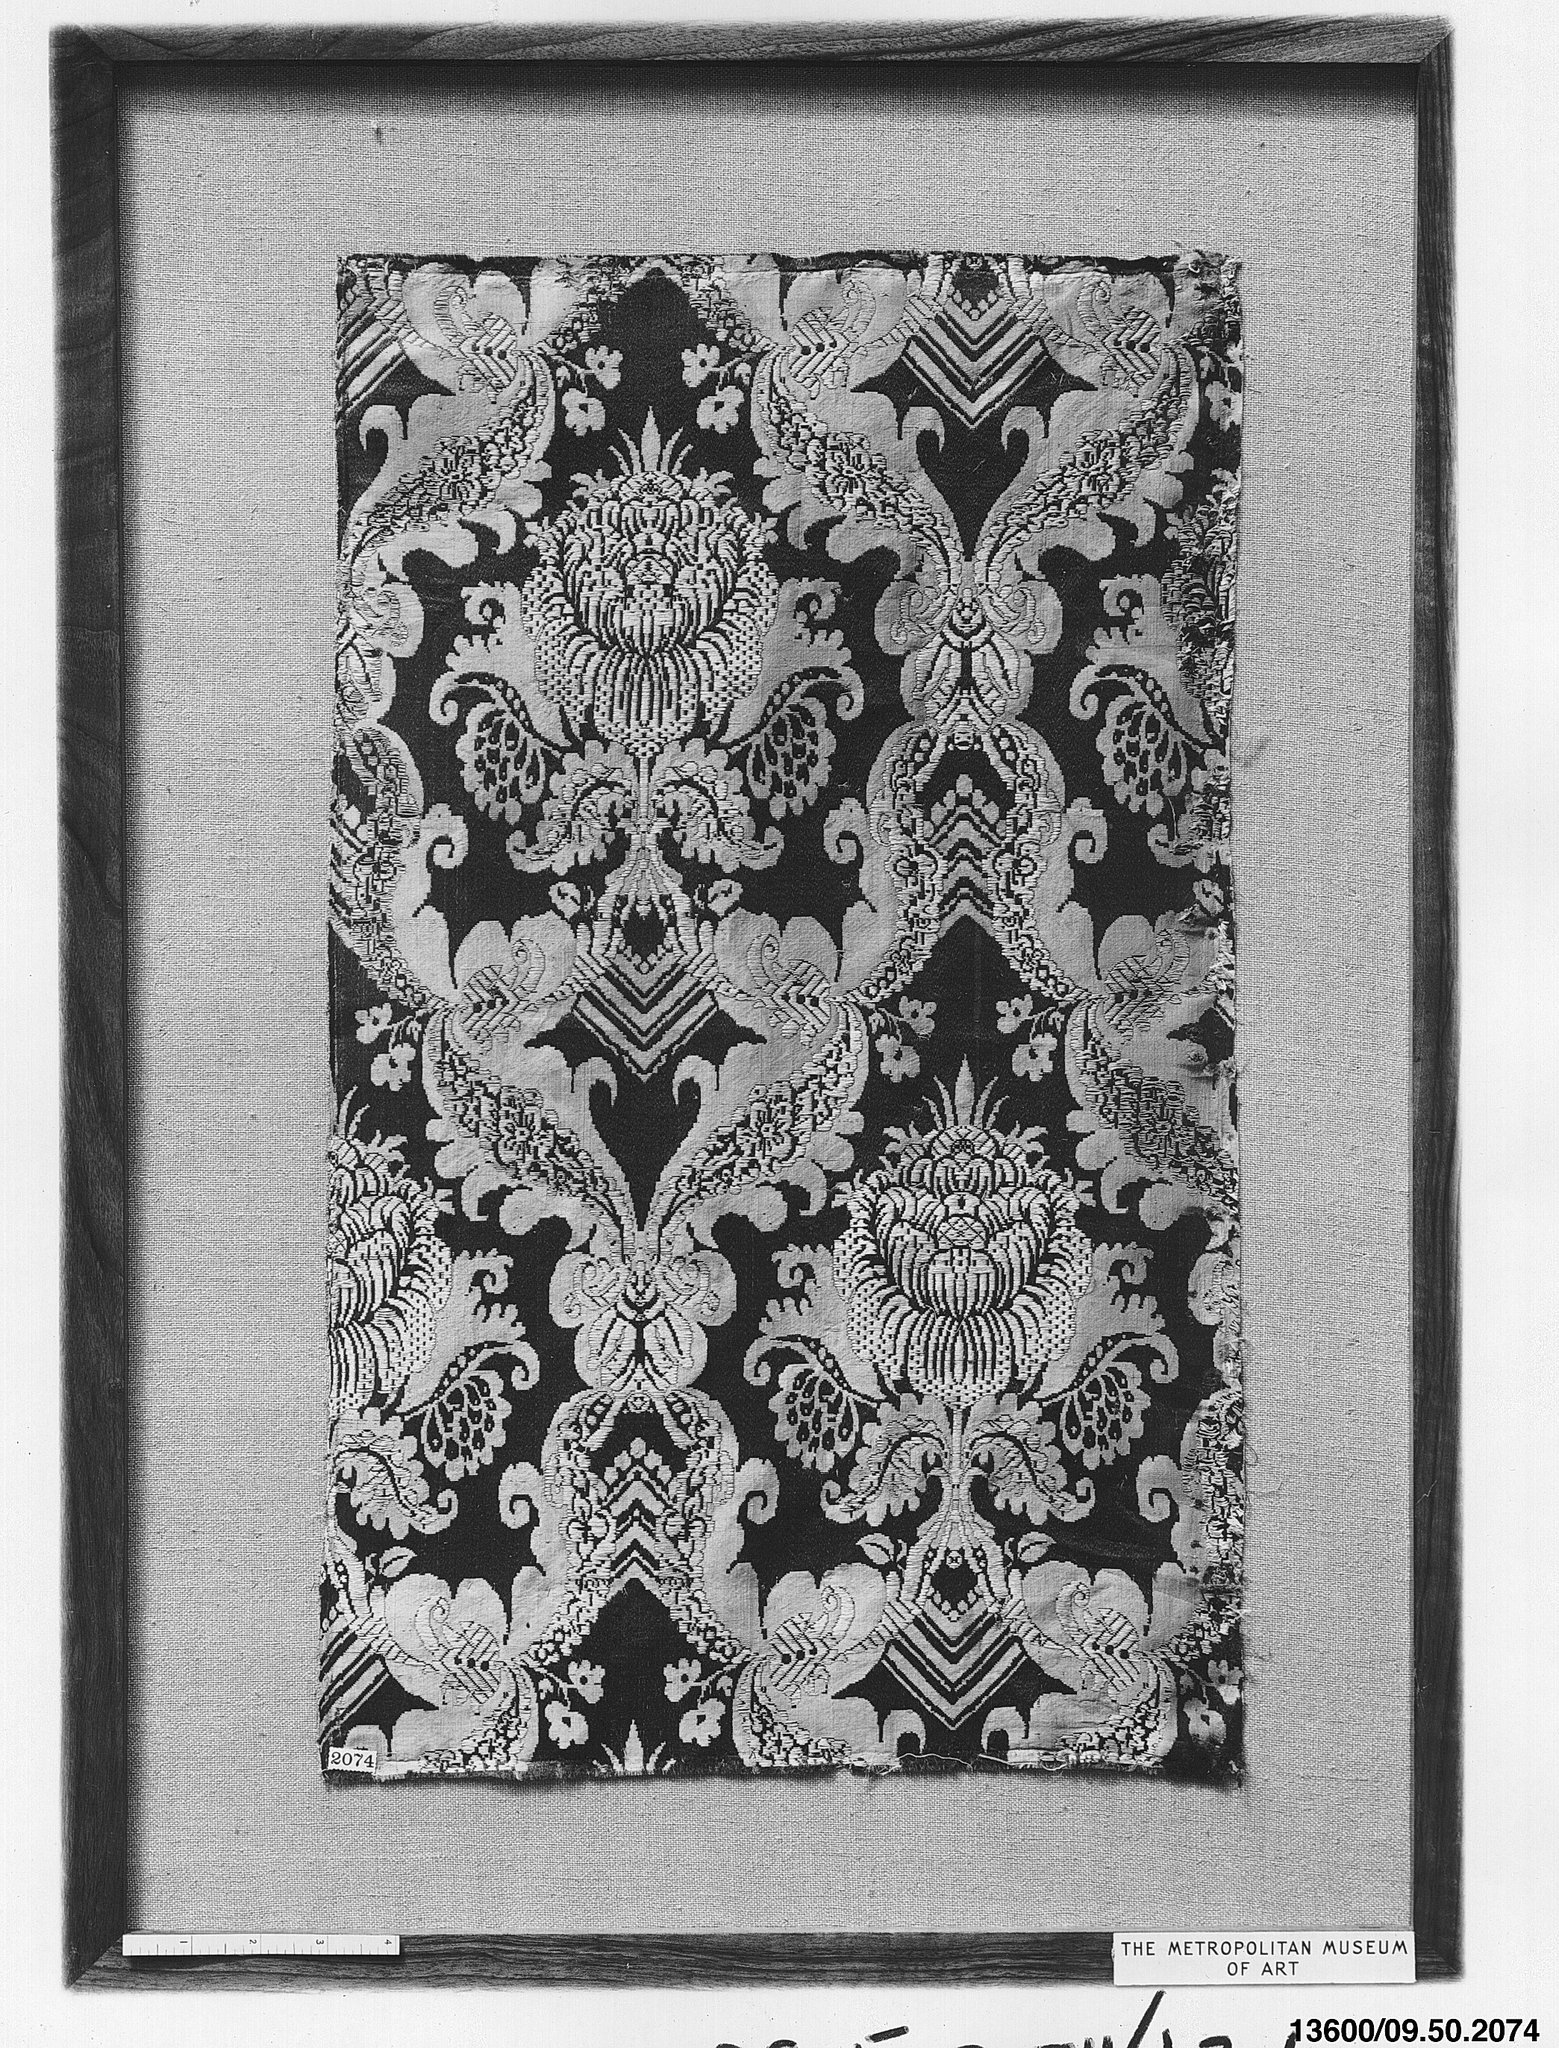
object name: piece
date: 1690-1700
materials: silk